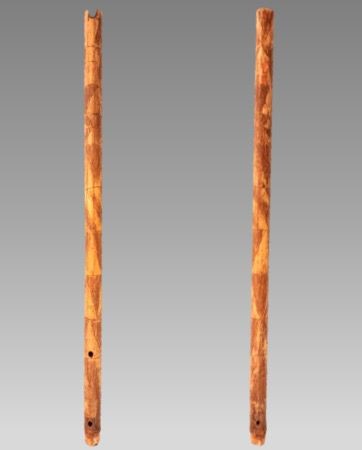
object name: gore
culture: melanesian, aoba island or vanuatuan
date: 1867-1900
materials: bamboo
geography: vanuatu